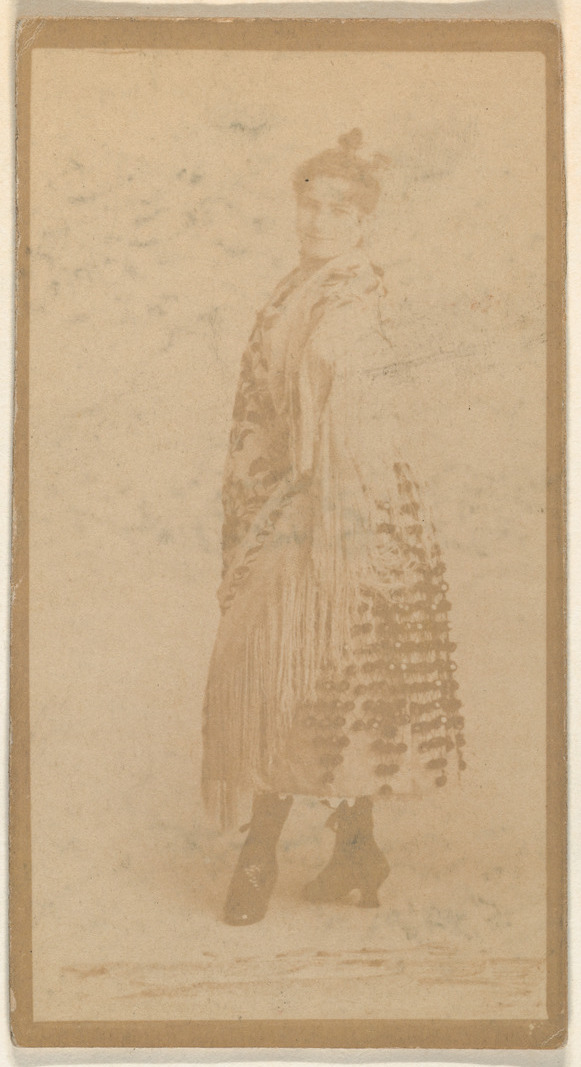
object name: photograph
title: Standing actress wrapped in shawl, from the Actresses series (N668)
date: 1888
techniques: albumen silver print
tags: portraits,women,actresses